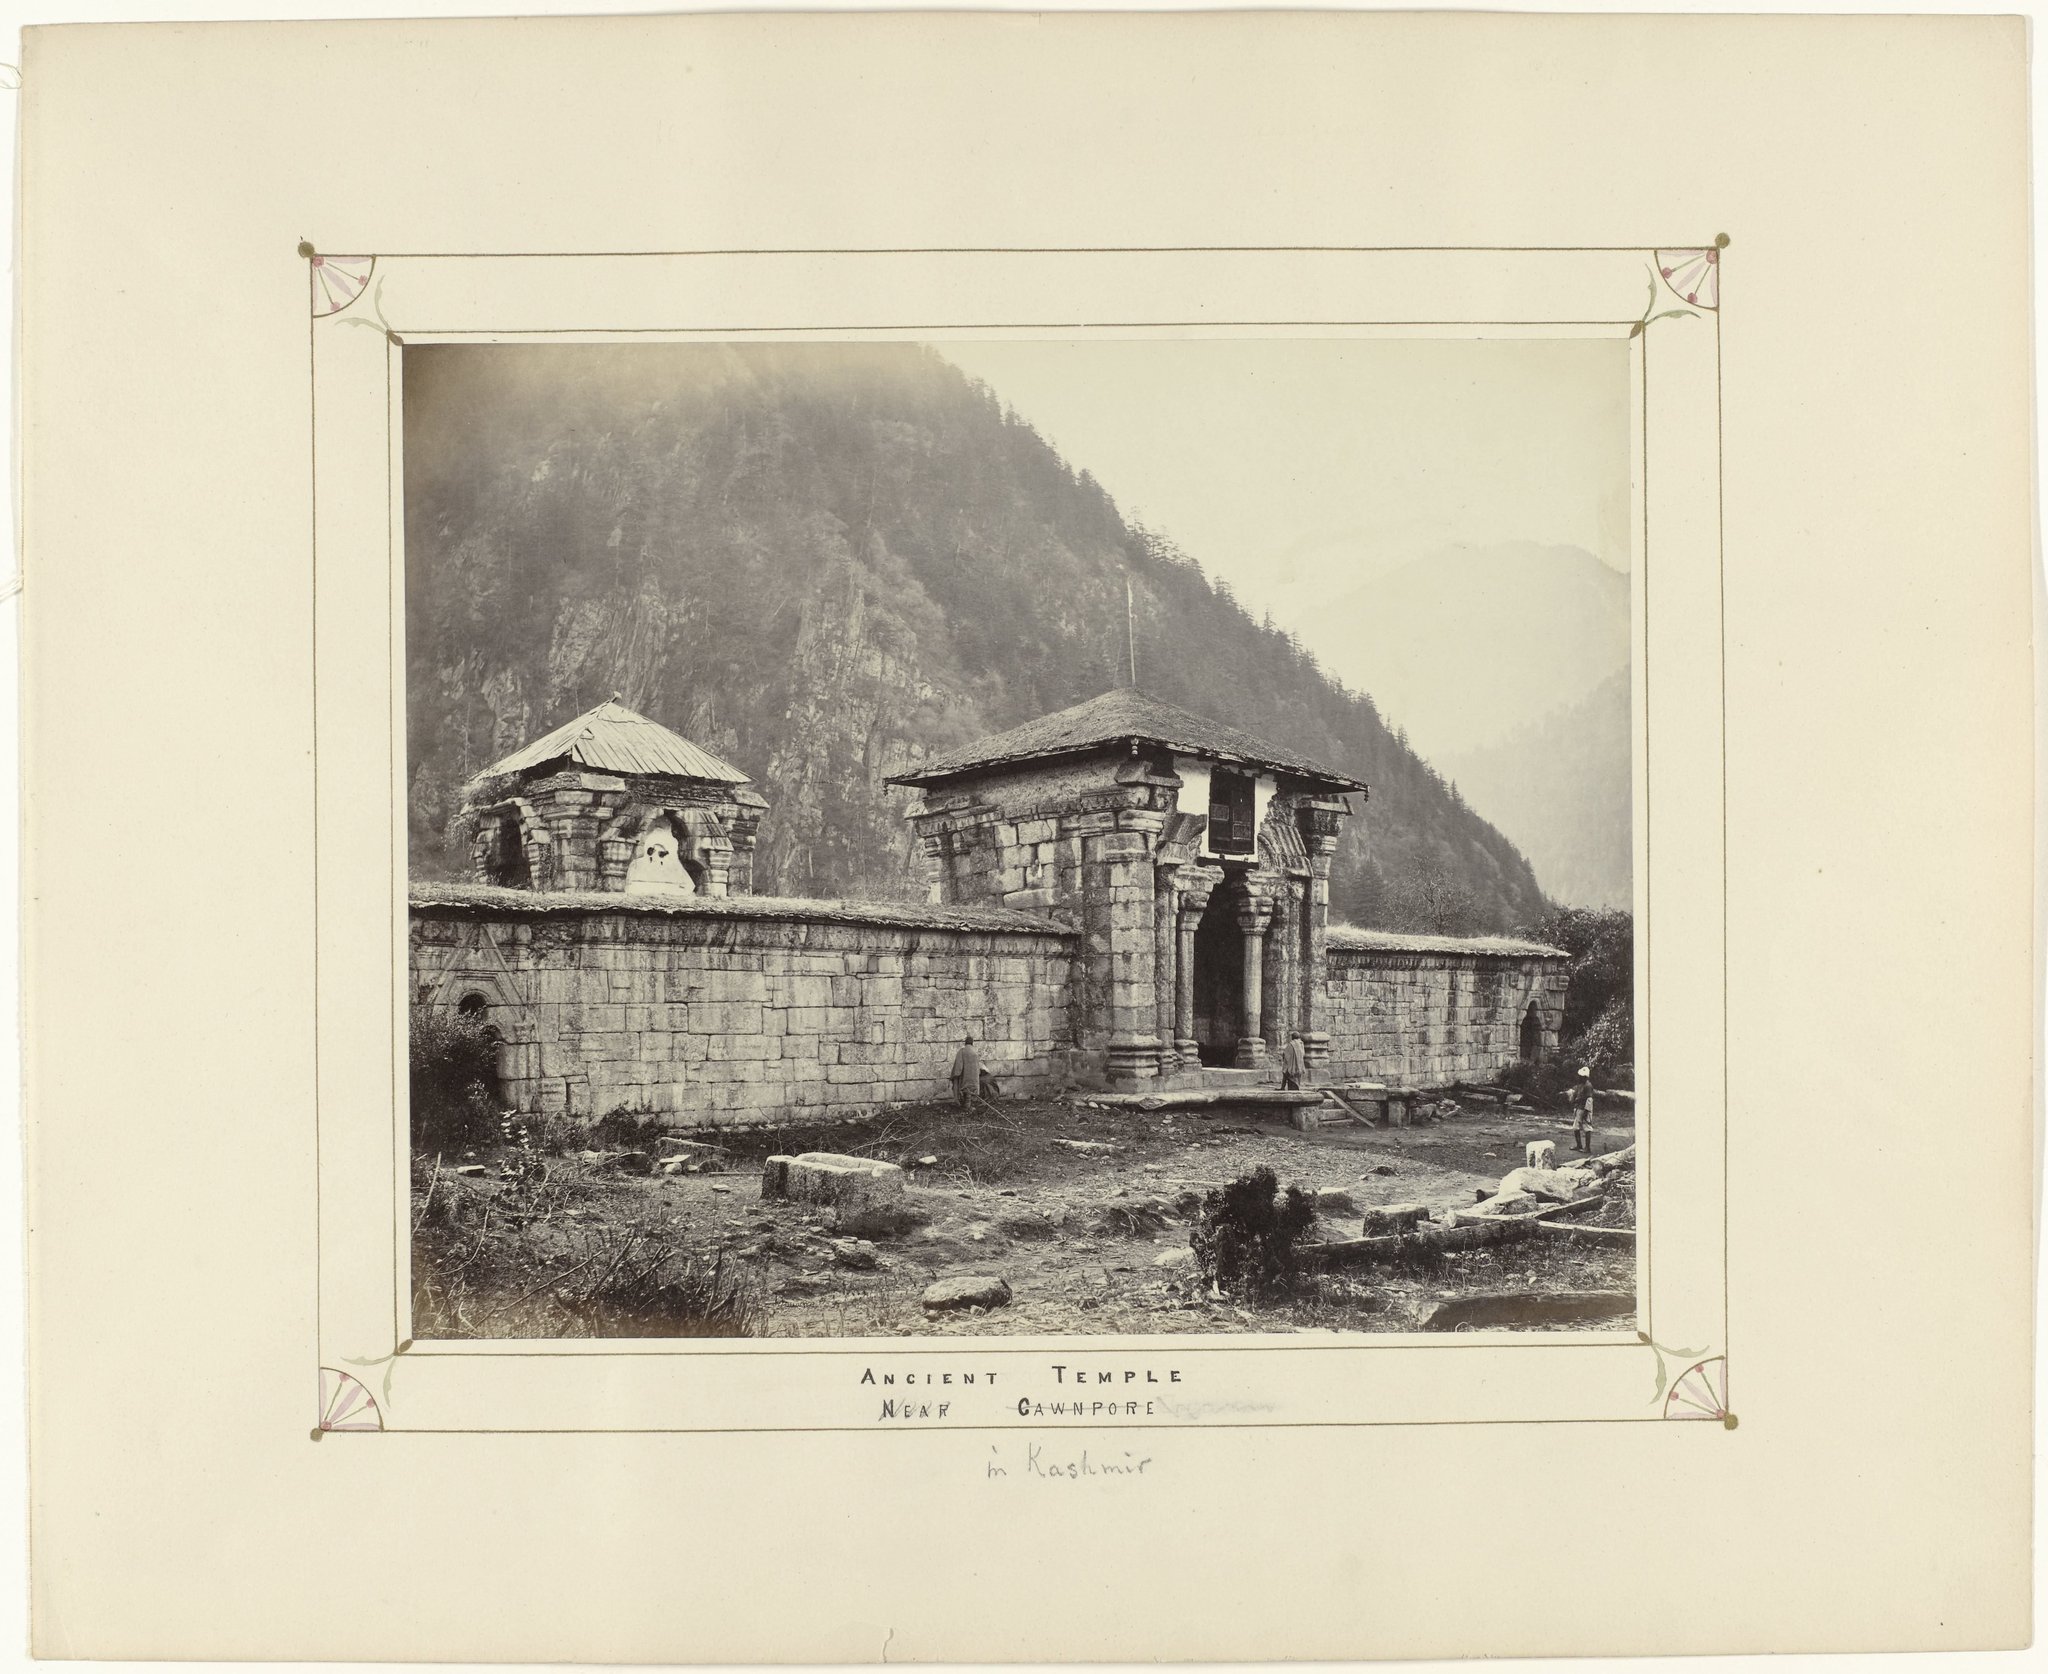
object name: photograph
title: Exterior of Buniyar temple near Baramulla, Jammu & Kashmir, India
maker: samuel bourne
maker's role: fotograaf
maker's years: 1834-1912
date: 1862-1874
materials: cardboard, paper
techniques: albumen print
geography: buniyar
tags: temple, shrine ~ hinduism, buddhism, jainism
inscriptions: title: ‘in Kashmir’, title: ‘ANCIENT TEMPLE NEAR CAWNPORE’